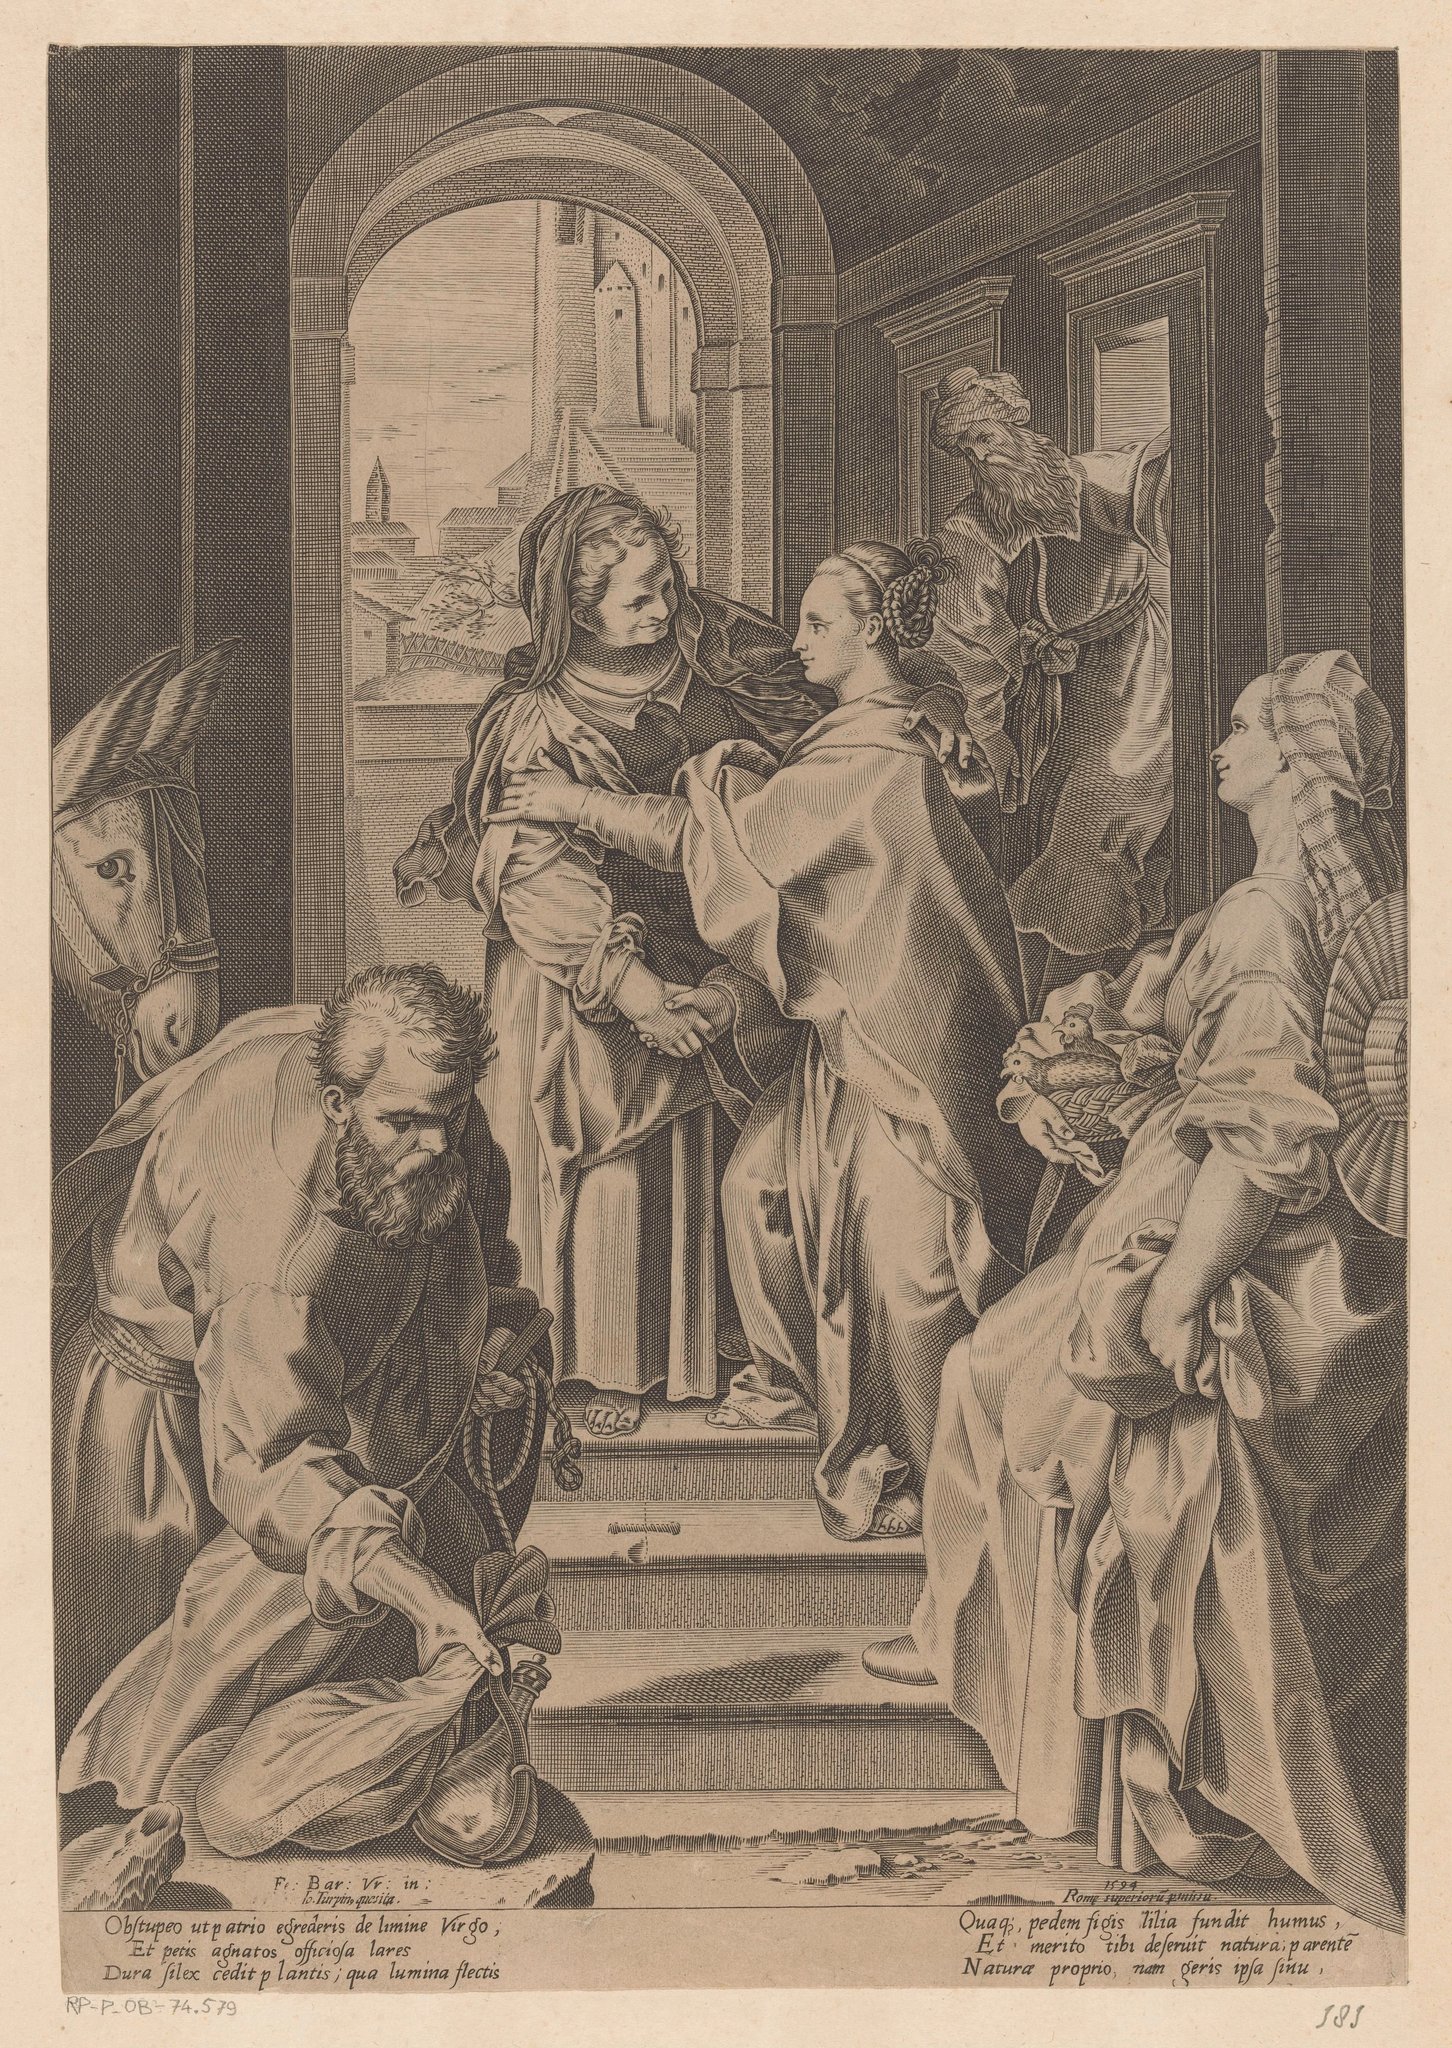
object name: print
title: Visitatie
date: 1594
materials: paper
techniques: engraving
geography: rome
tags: visitation (possibly joseph and/or zacharias present) (luke 1:39-56)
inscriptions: collector's mark: Lugt 240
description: Het originele schilderij door Barocci bevindt zich in de Santa Maria in Vallicella te Rome.